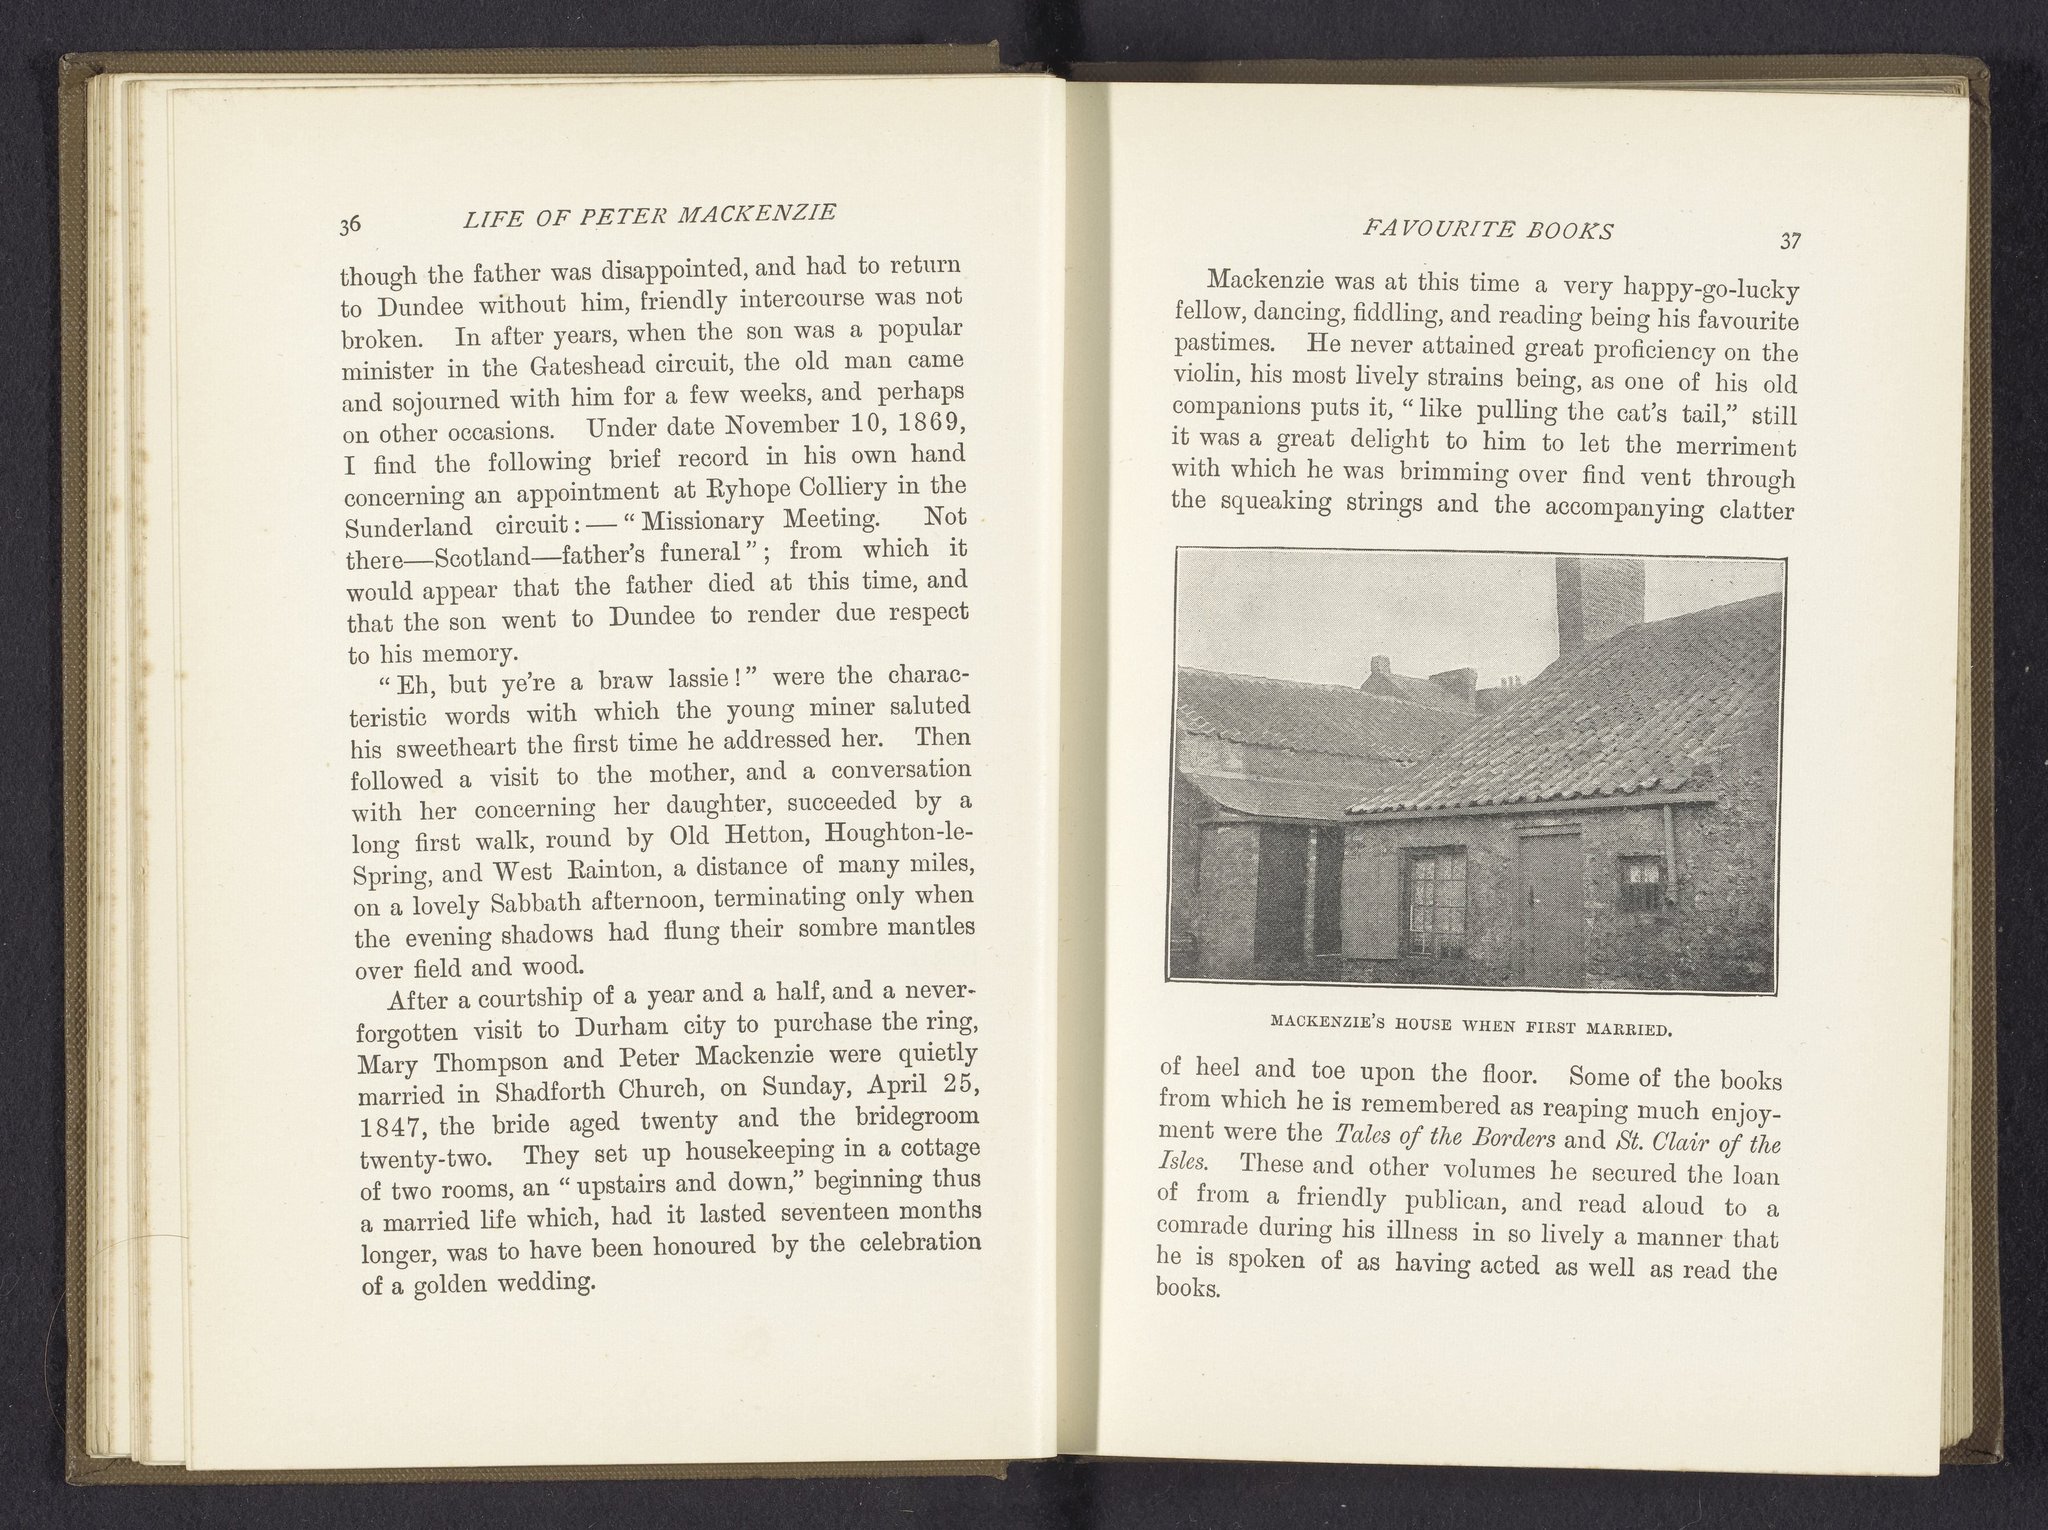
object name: page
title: Mackenzie's house when first married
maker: Anonymous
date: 1887-1897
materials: paper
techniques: autotype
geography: haswell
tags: housing, façade (of house or building)